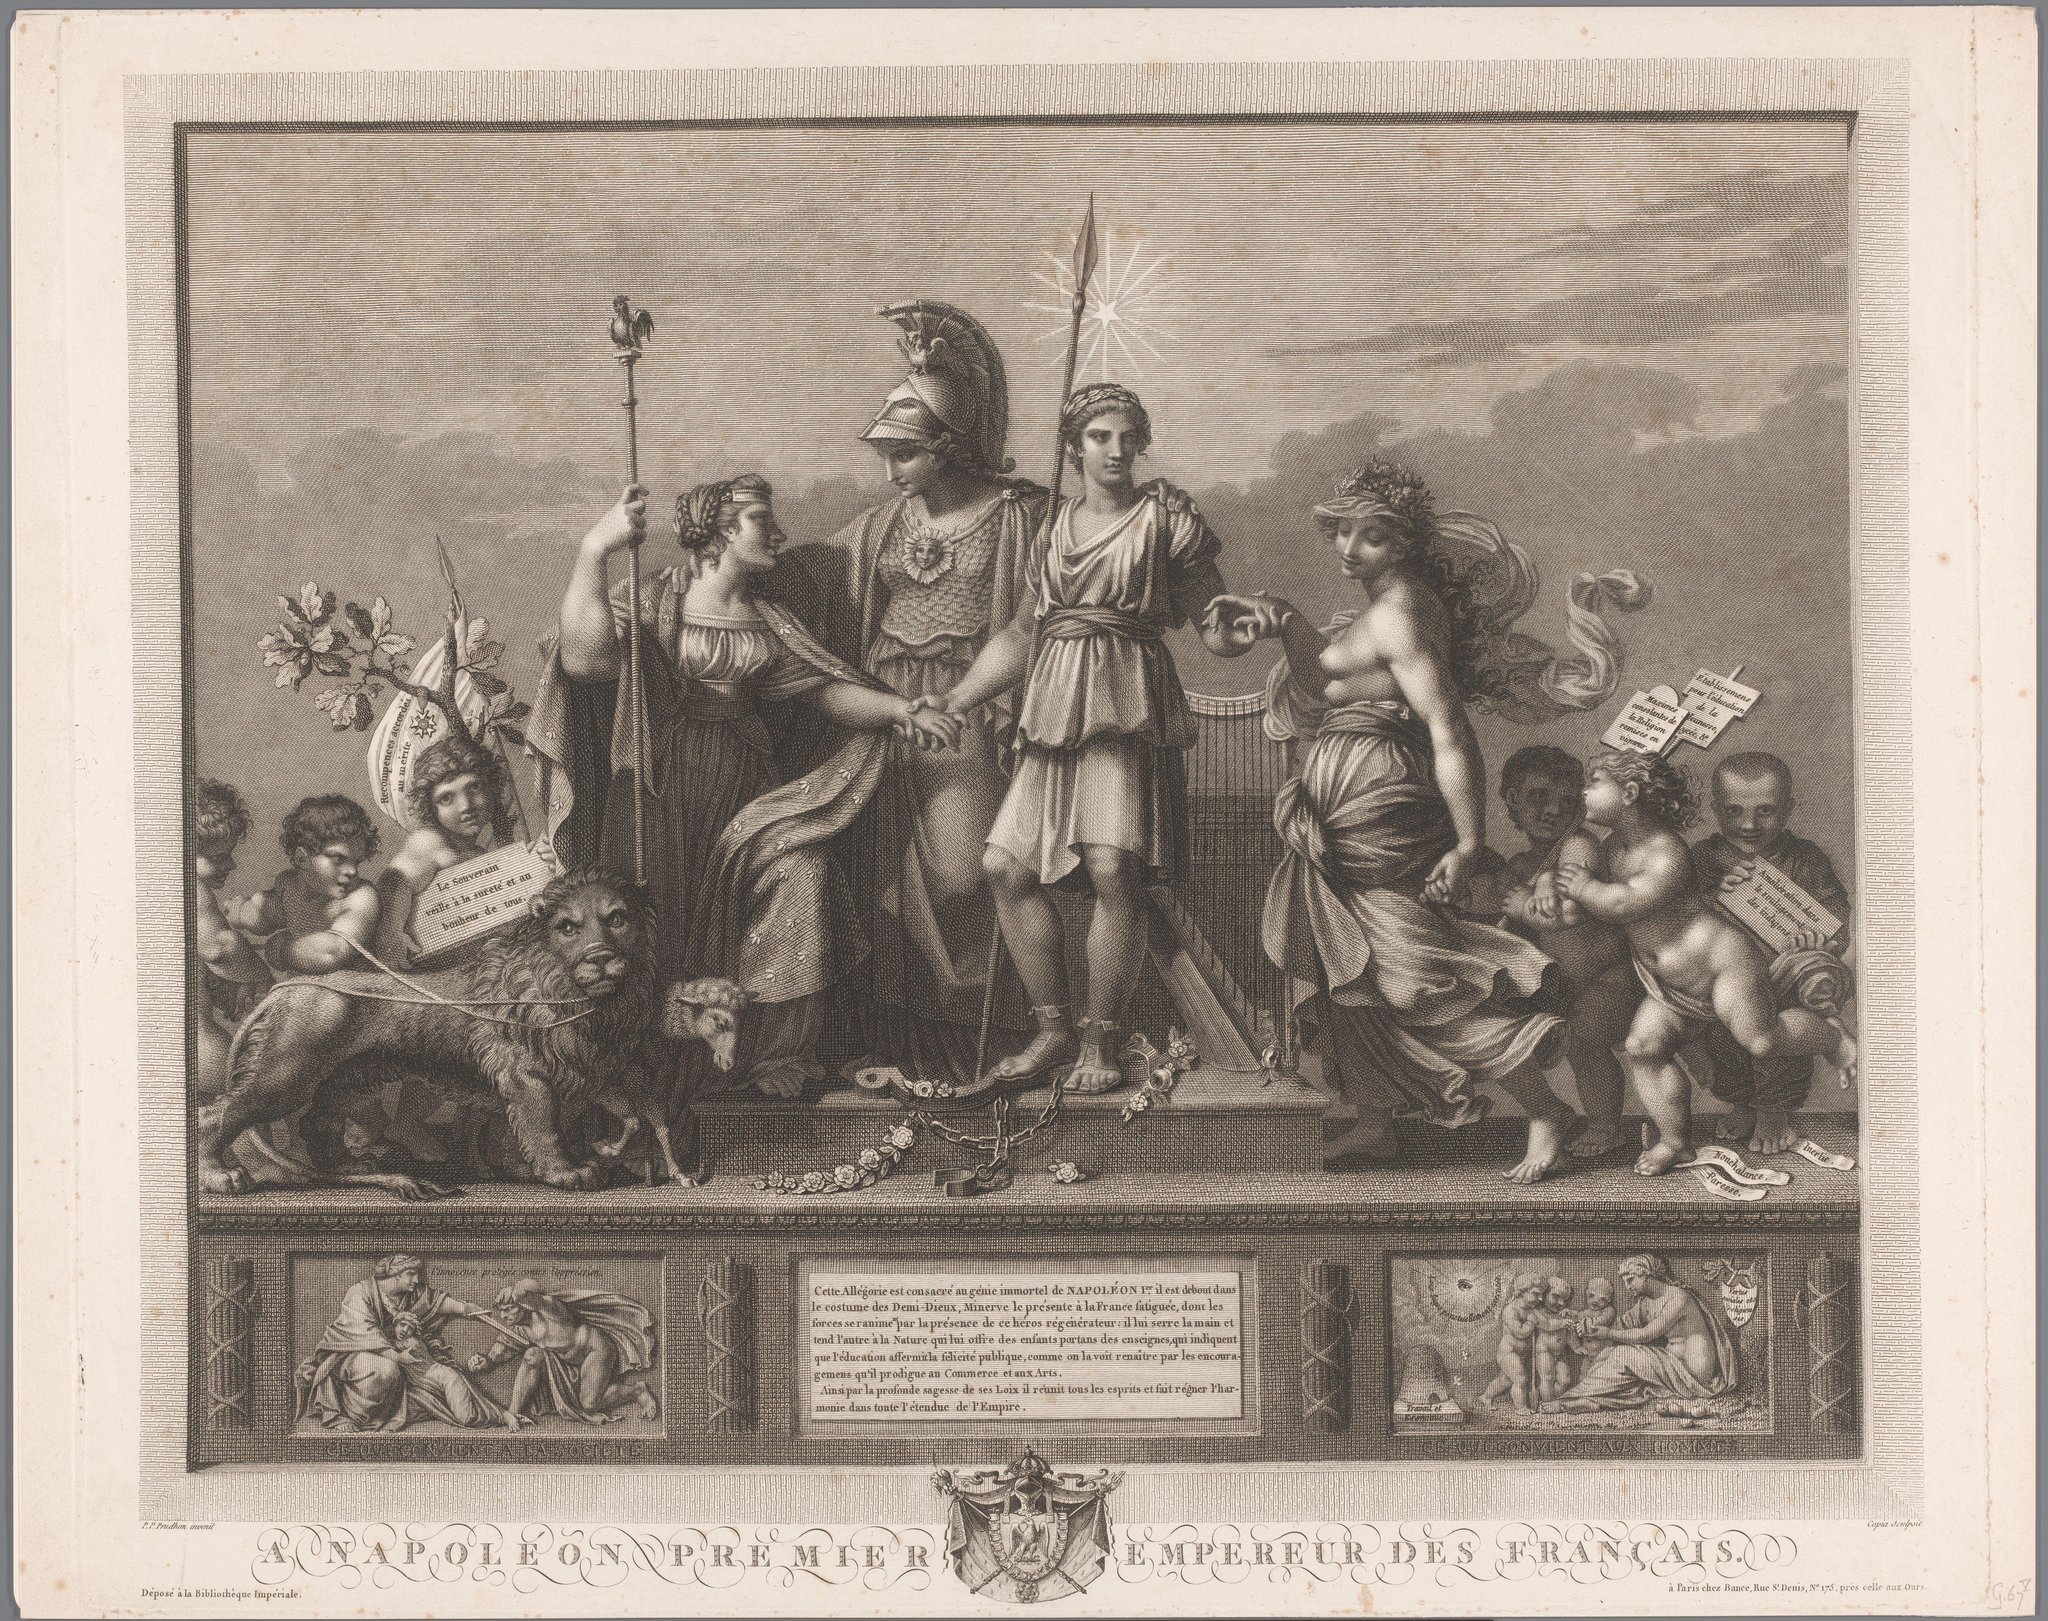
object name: print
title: Allegorie op de Franse constitutie en Napoleon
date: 1804-1847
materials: paper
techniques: engraving, etching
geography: paris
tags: napoleon i (emperor of the french), 'natura' (allegorical figure or scene; or as diana of ephesus, with many breasts); 'natura' (ripa), minerva as patroness, historical persons, freedom, liberty; 'libertà' (ripa), equality, equity, fairness, righteousness; 'equalità', 'equità', 'giuditio giusto', 'ordine dritto e giusto', 'ugualità' (ripa)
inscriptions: collector's mark: Lugt 2228, : ‘Déposé à la Bibliothèque Impériale’, collector's mark: Lugt 2760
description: Minerva en Napoleon laten Frankrijk en de Natuur elkaar de hand reiken.